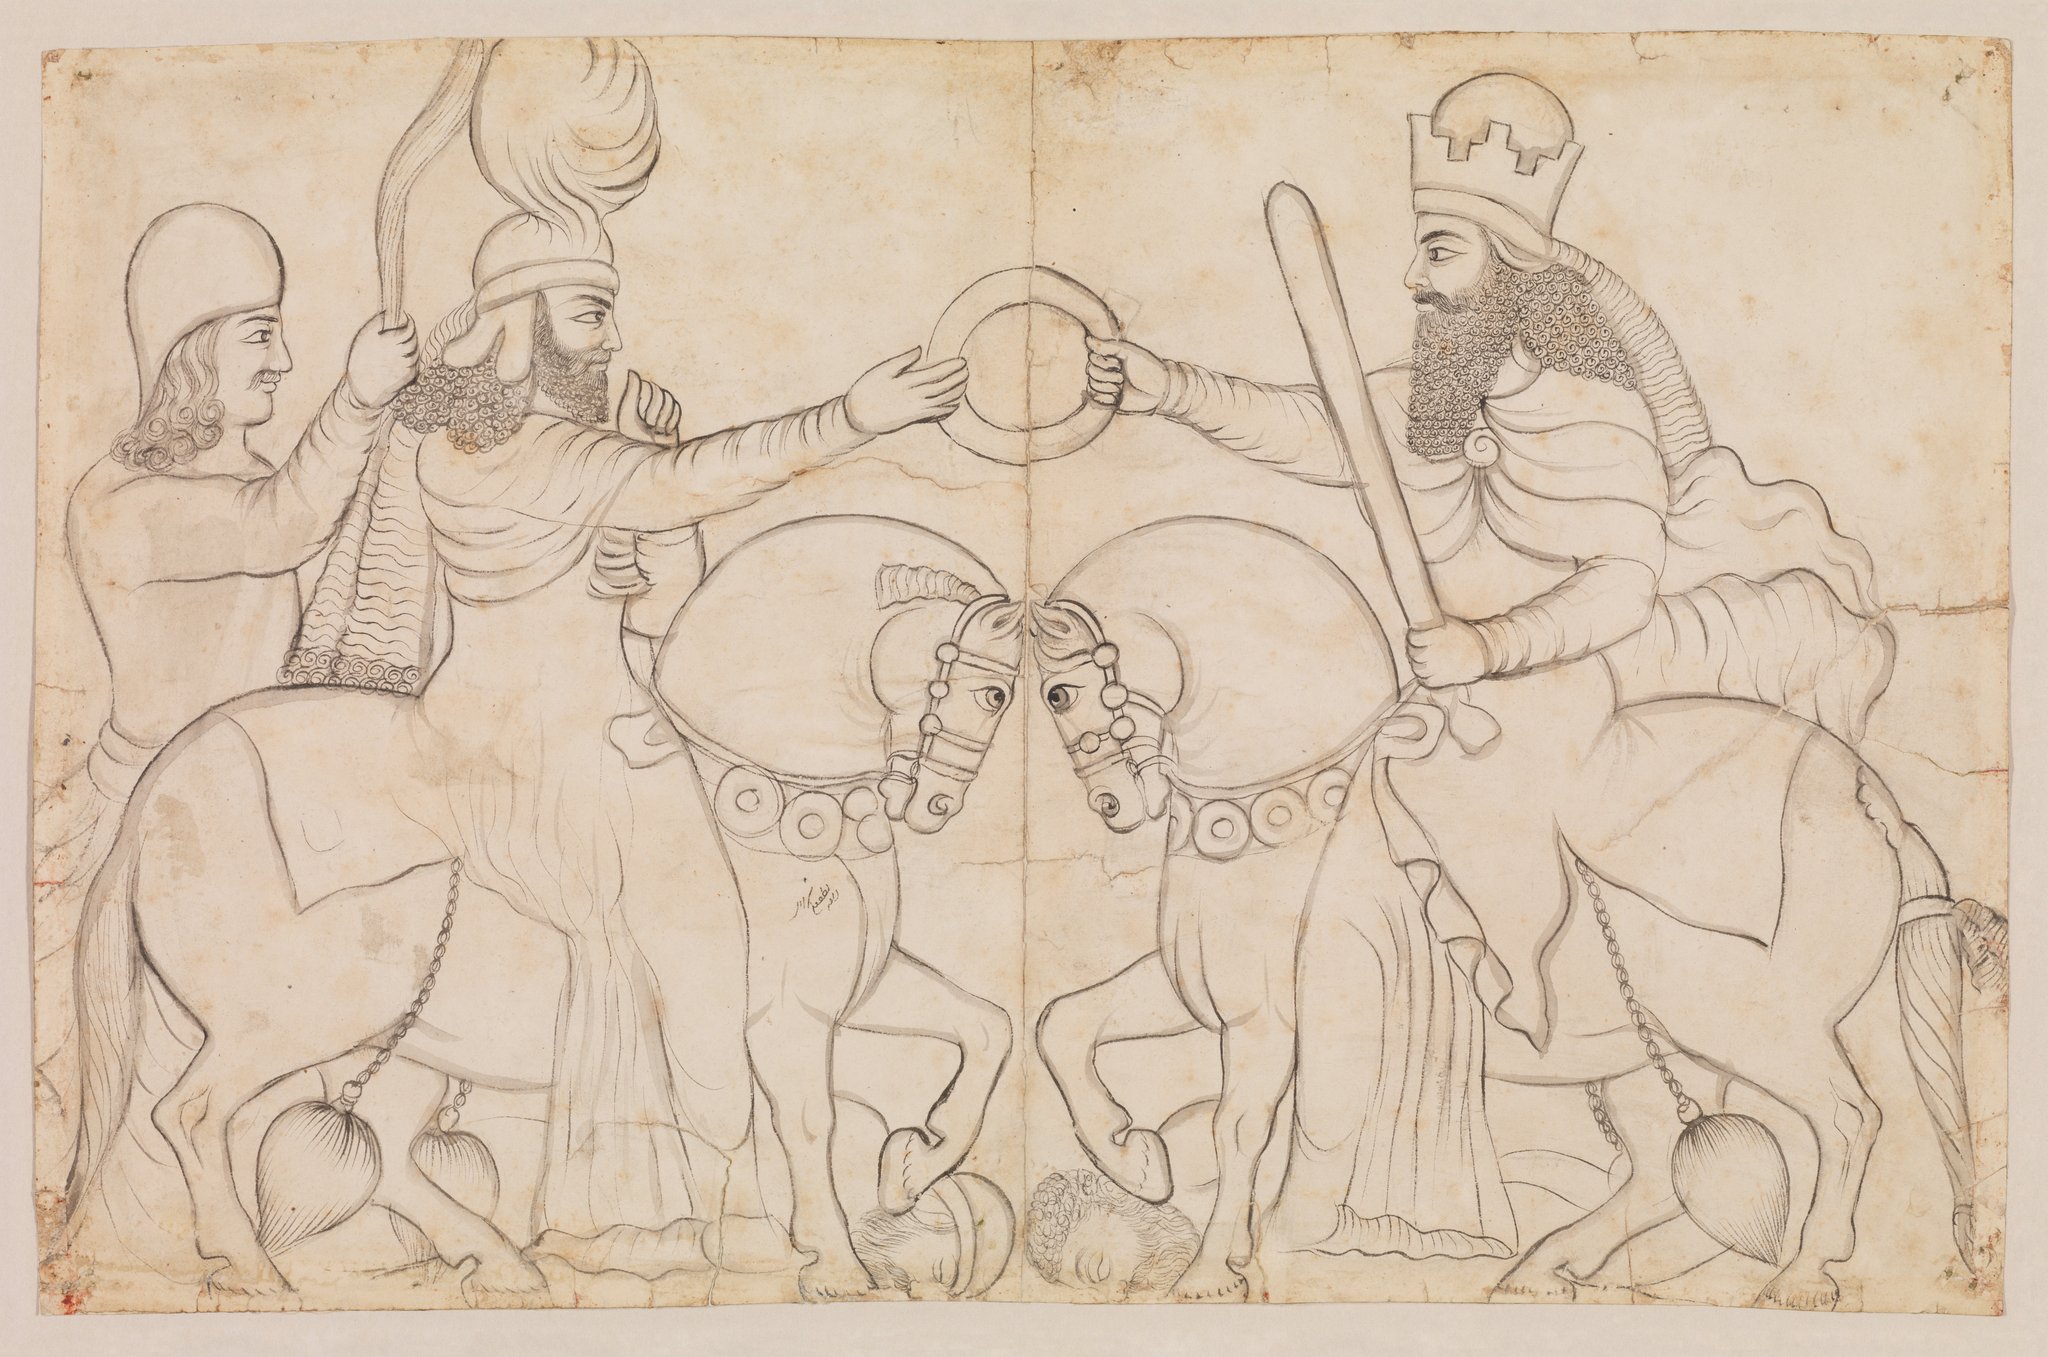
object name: drawing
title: Drawing of Sasanian rock relief: Ardashir I (r. A.D. 224-241) and the Zoroastrian divinity Ohrmazd [Ahura Mazda] at Naqsh-i Rustam, southern Iran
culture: qajar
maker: lutf-'ali shirazi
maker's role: artist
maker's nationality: iranian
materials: ink, paper, pencil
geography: iran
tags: kings,men,horses